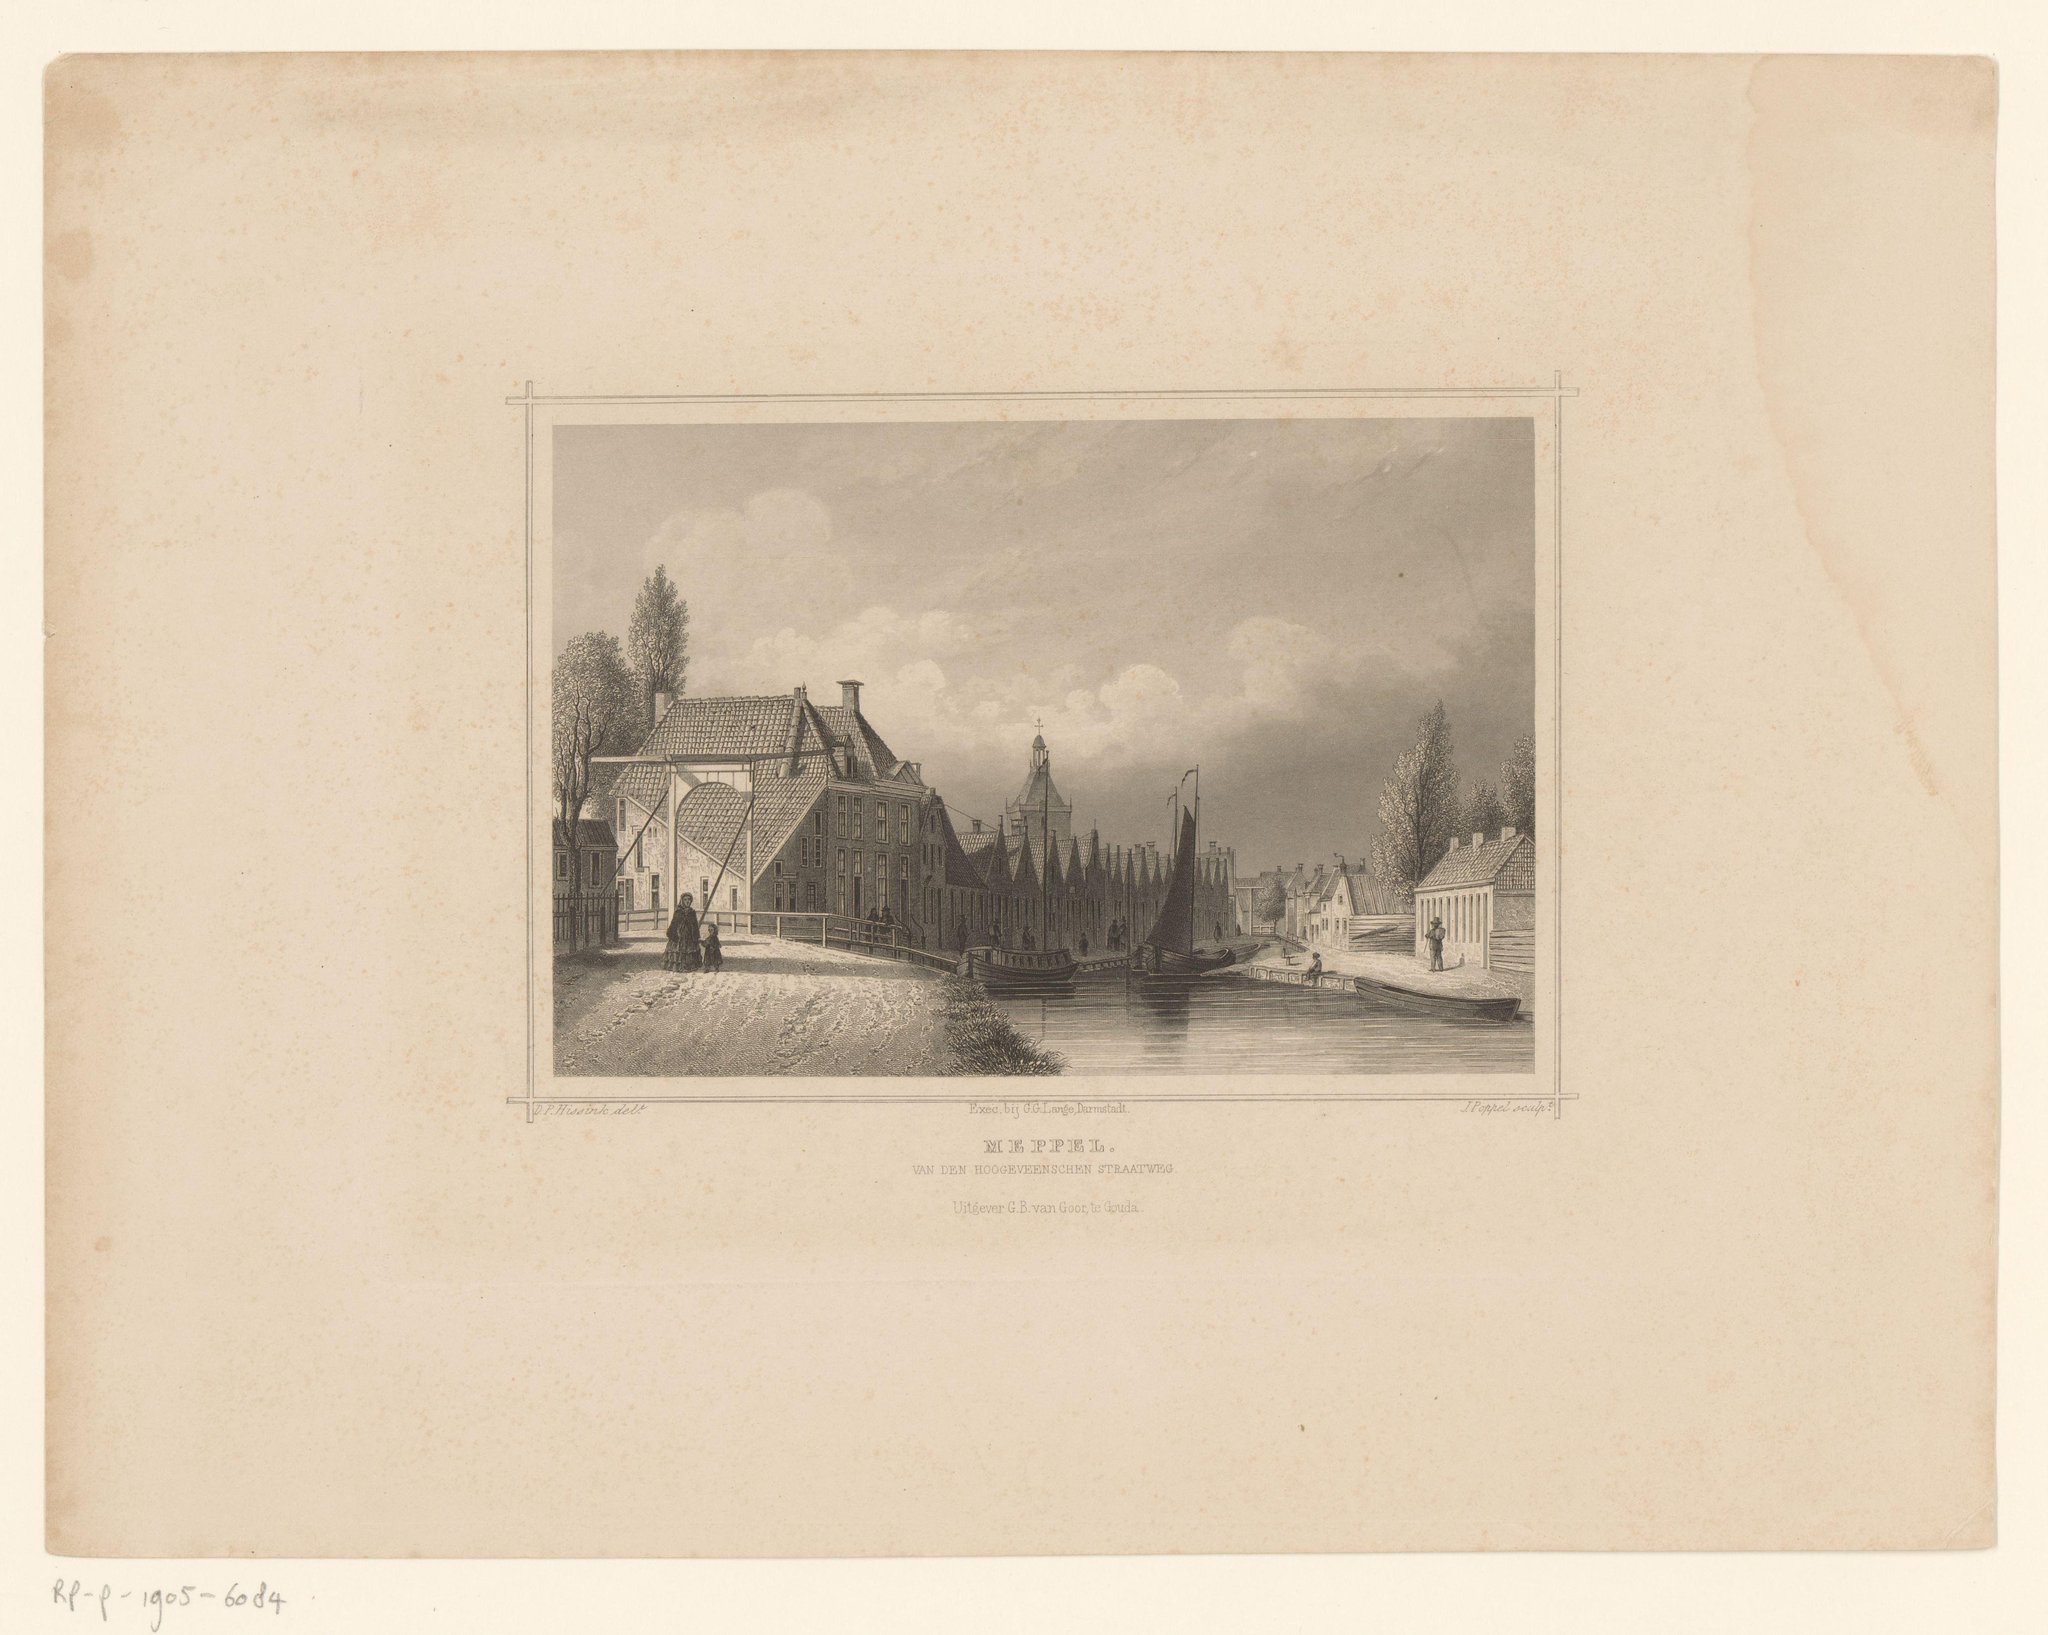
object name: print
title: Meppel. Van den Hoogeveenschen Straatweg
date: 1858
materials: paper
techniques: engraving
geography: gouda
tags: harbour, city-view, and landscape with man-made constructions, ships (in general) - cc - more than one ship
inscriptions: collector's mark: Lugt 2228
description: Prent ook gebruikt in: Terwen, Johannes Leonardus. Het Koningrijk der Nederlanden voorgesteld in eene reeks van naar de natuur geteekende schilderachtige gezigten. Gouda: Van Goor, 1858-1862.